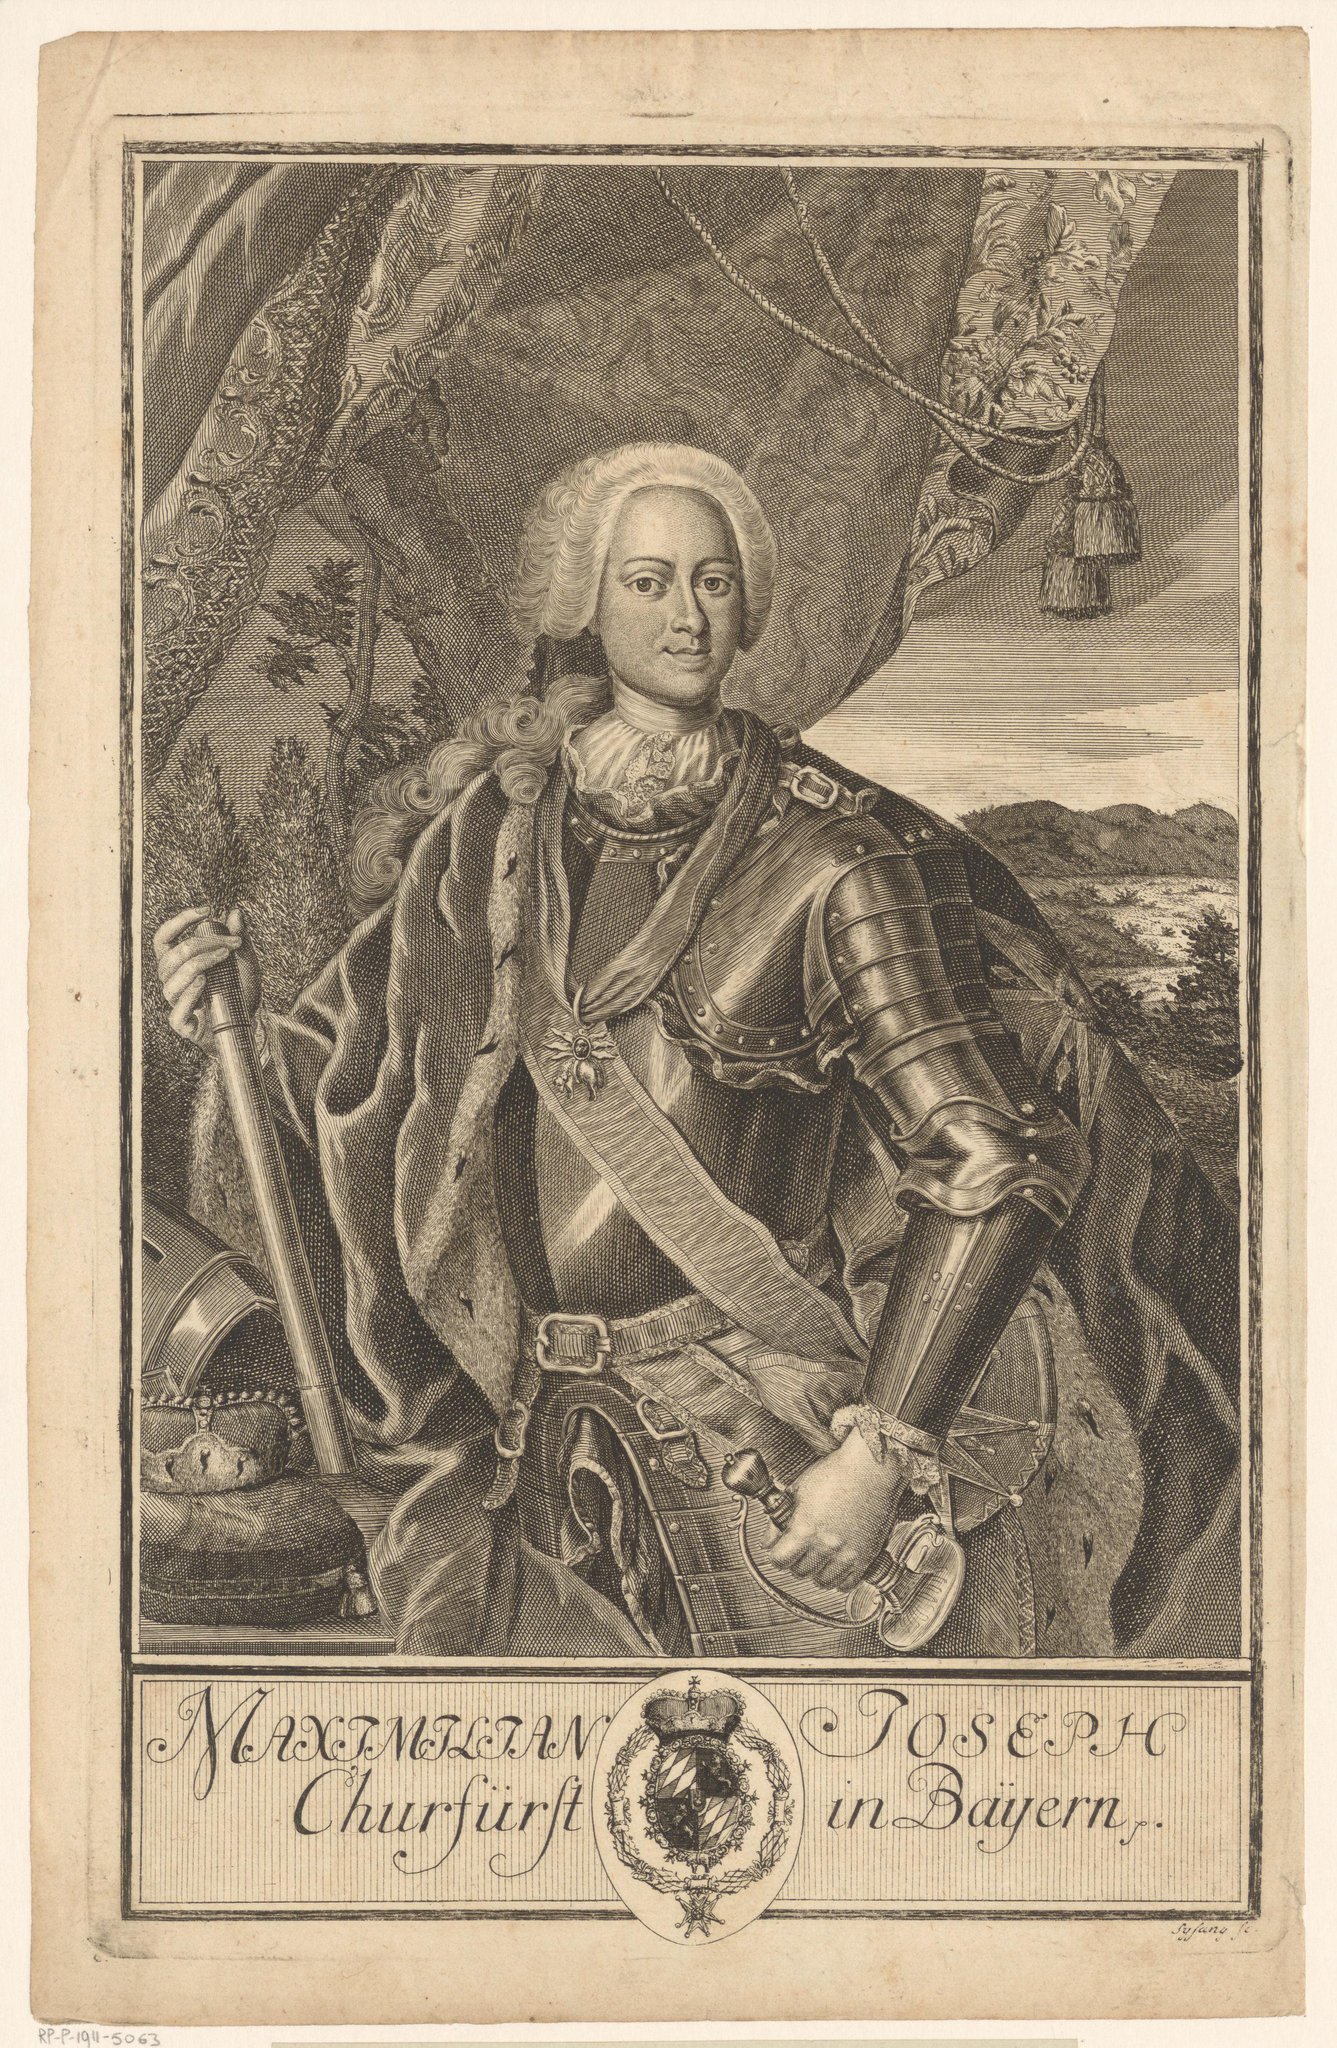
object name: print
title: Portret van Maximiliaan III Jozef van Beieren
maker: johann christoph sysang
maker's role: print maker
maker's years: 1703-1757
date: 1745-1757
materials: paper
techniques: engraving, etching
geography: leipzig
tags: armour, historical persons, knighthood order of the golden fleece - insignia of a knighthood order, e.g.: badge, chain (with name of order), baton of general, armorial bearing, heraldry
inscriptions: collector's mark: Lugt 2228